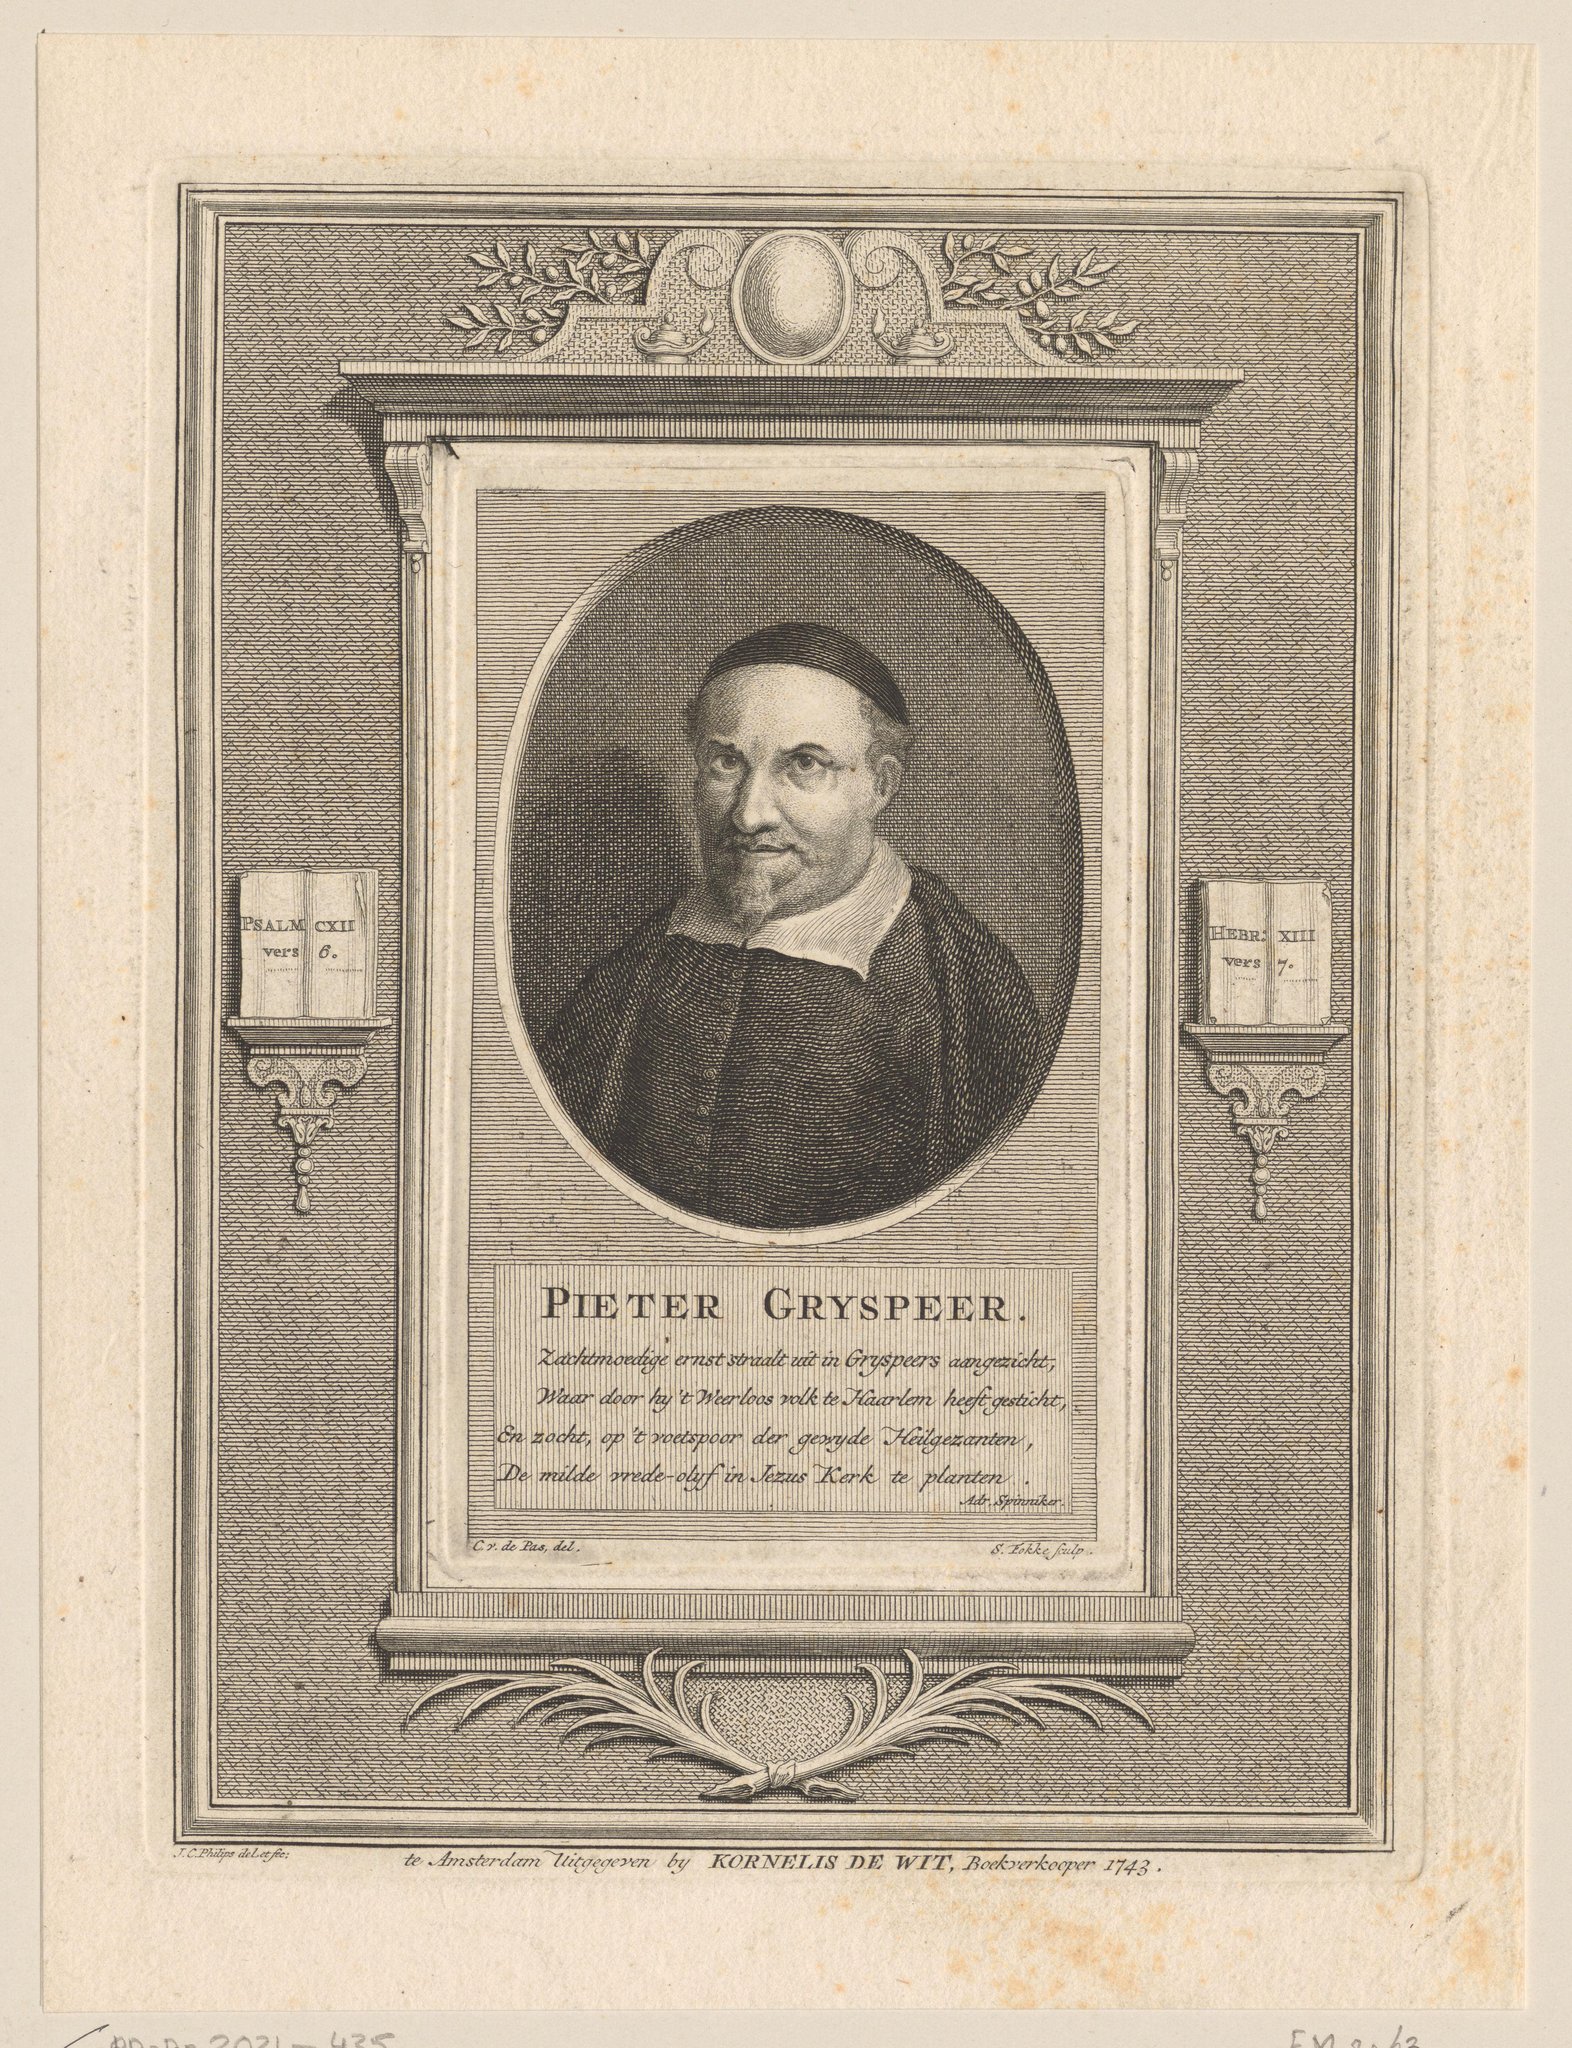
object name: print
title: Portret van Pieter Grijspeer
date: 1743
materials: paper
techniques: engraving, etching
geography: amsterdam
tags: theologian, further education, historical persons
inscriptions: date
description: Tekst in het Nederlands in de ondermarge.